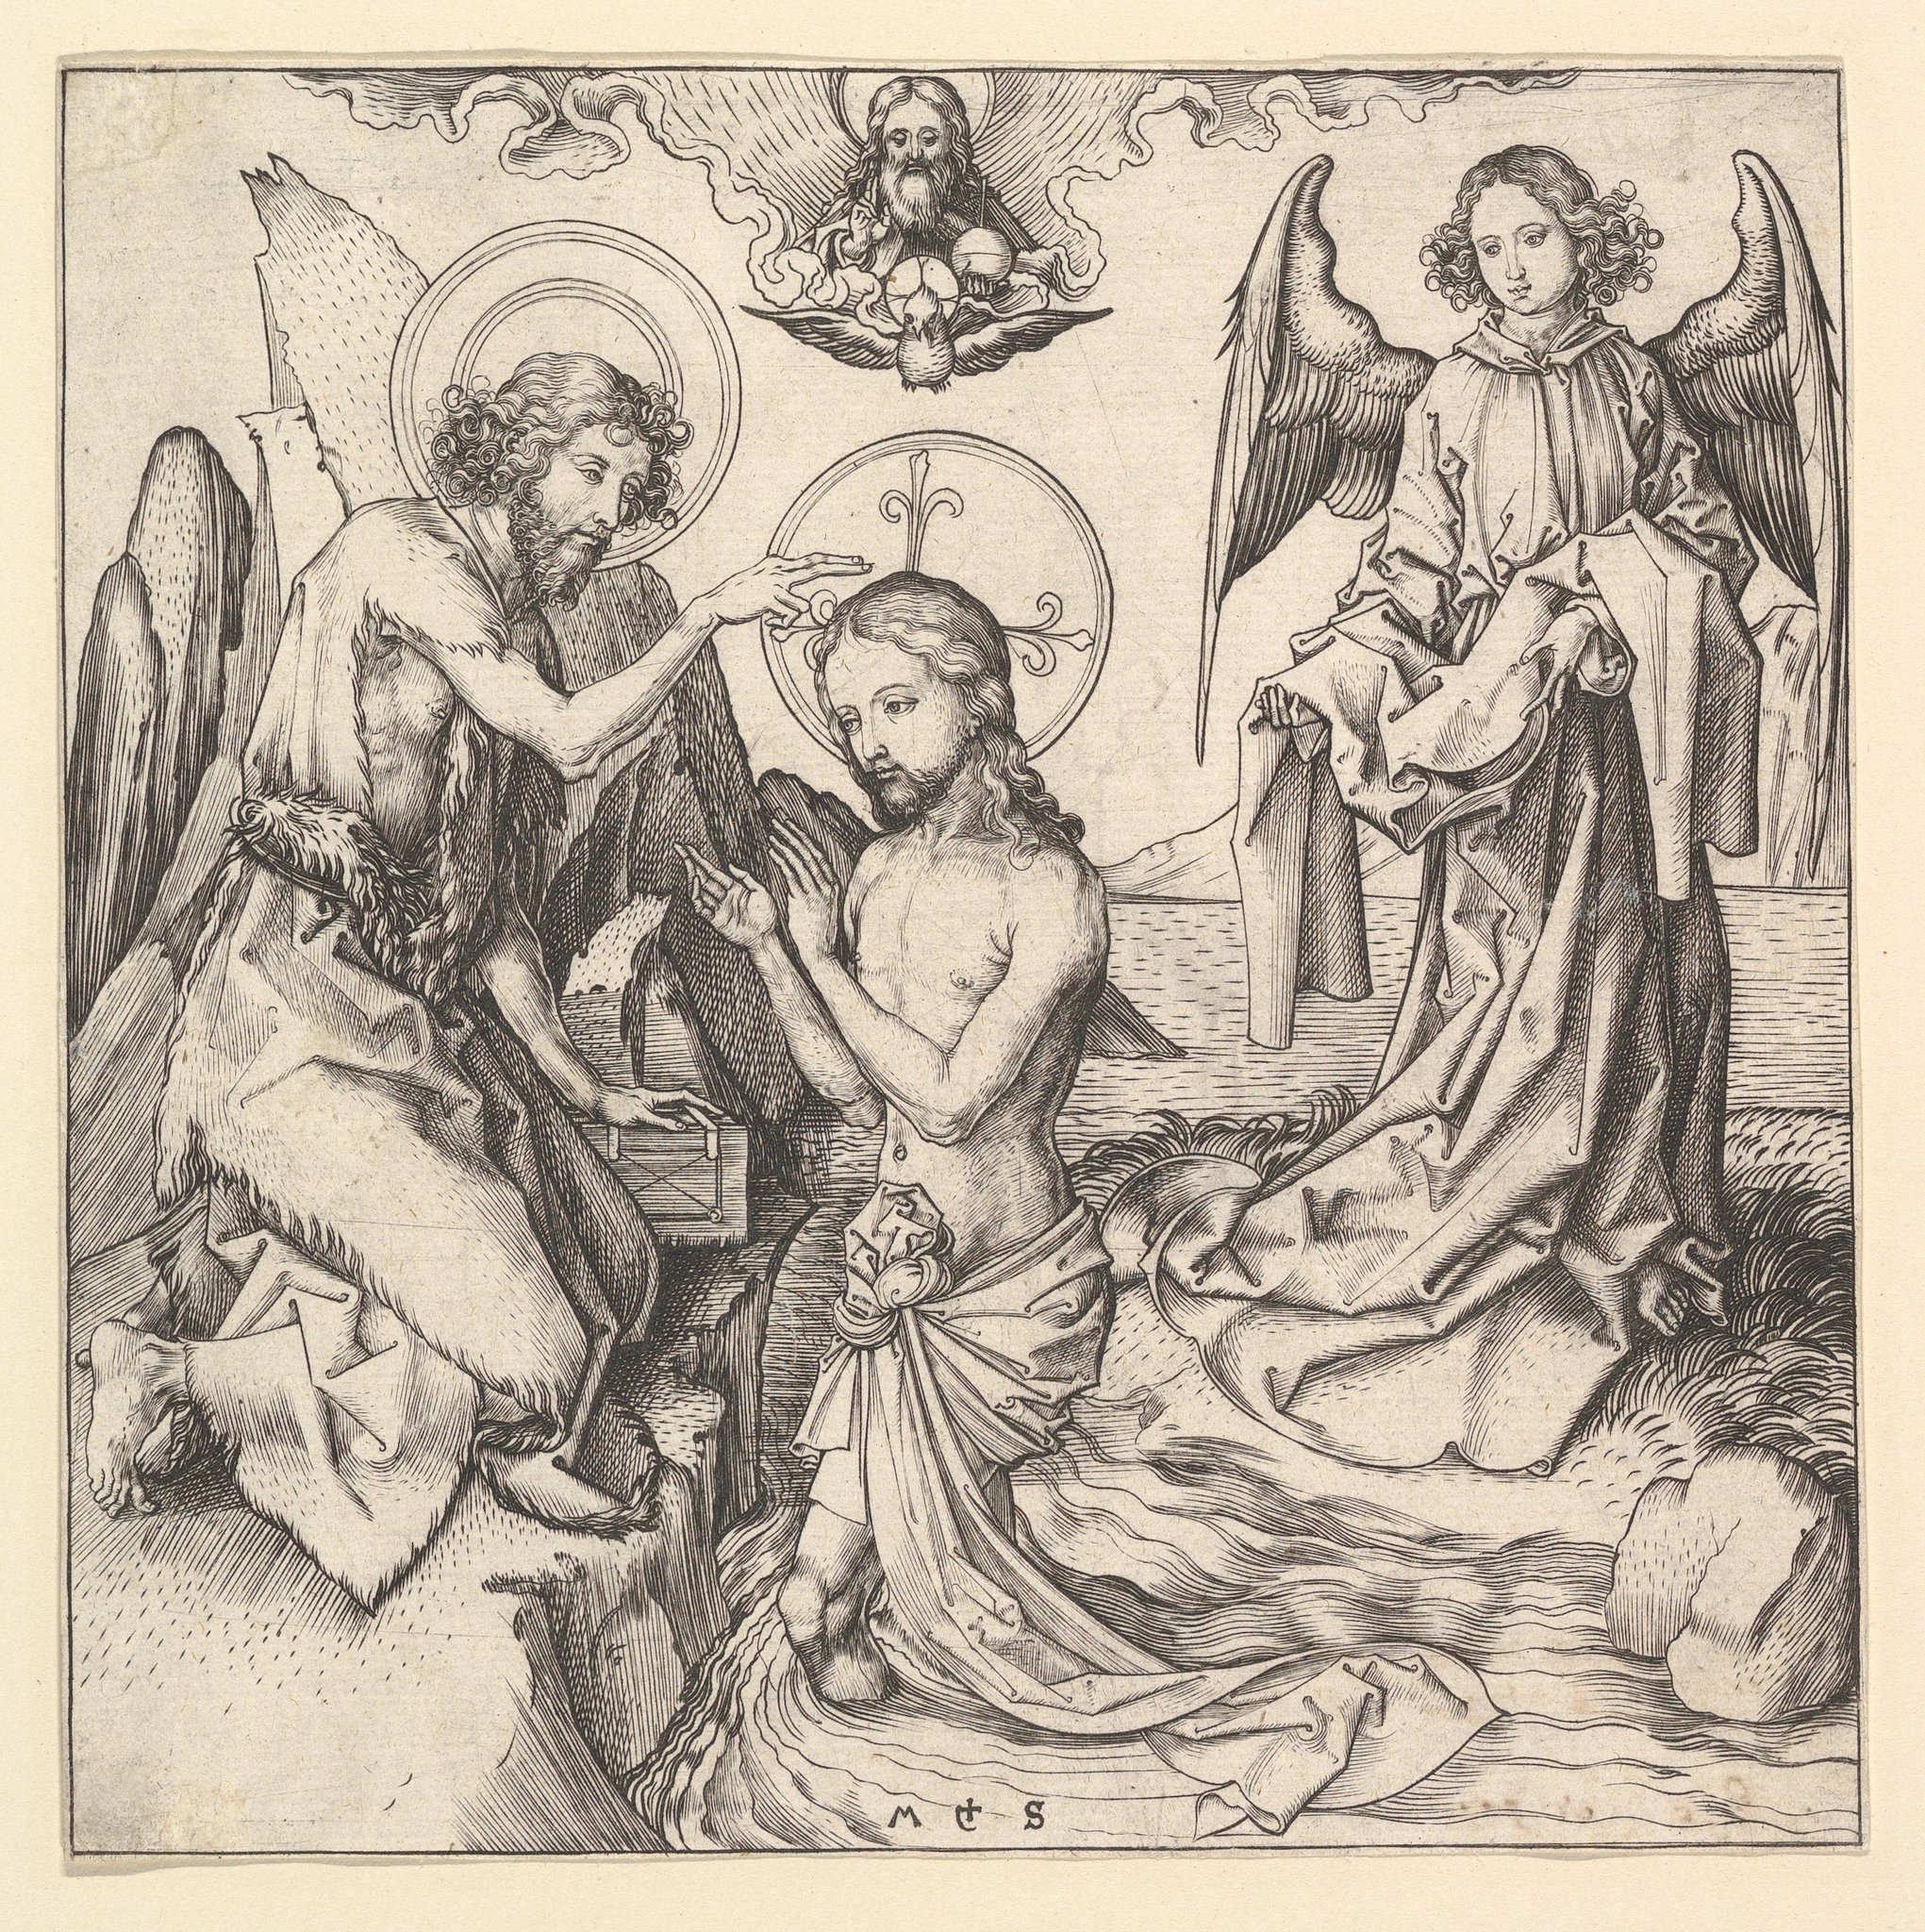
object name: print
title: Baptism of Christ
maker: martin schongauer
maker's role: artist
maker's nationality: german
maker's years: 1430-1491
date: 1470-1474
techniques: engraving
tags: angels,baptism of christ